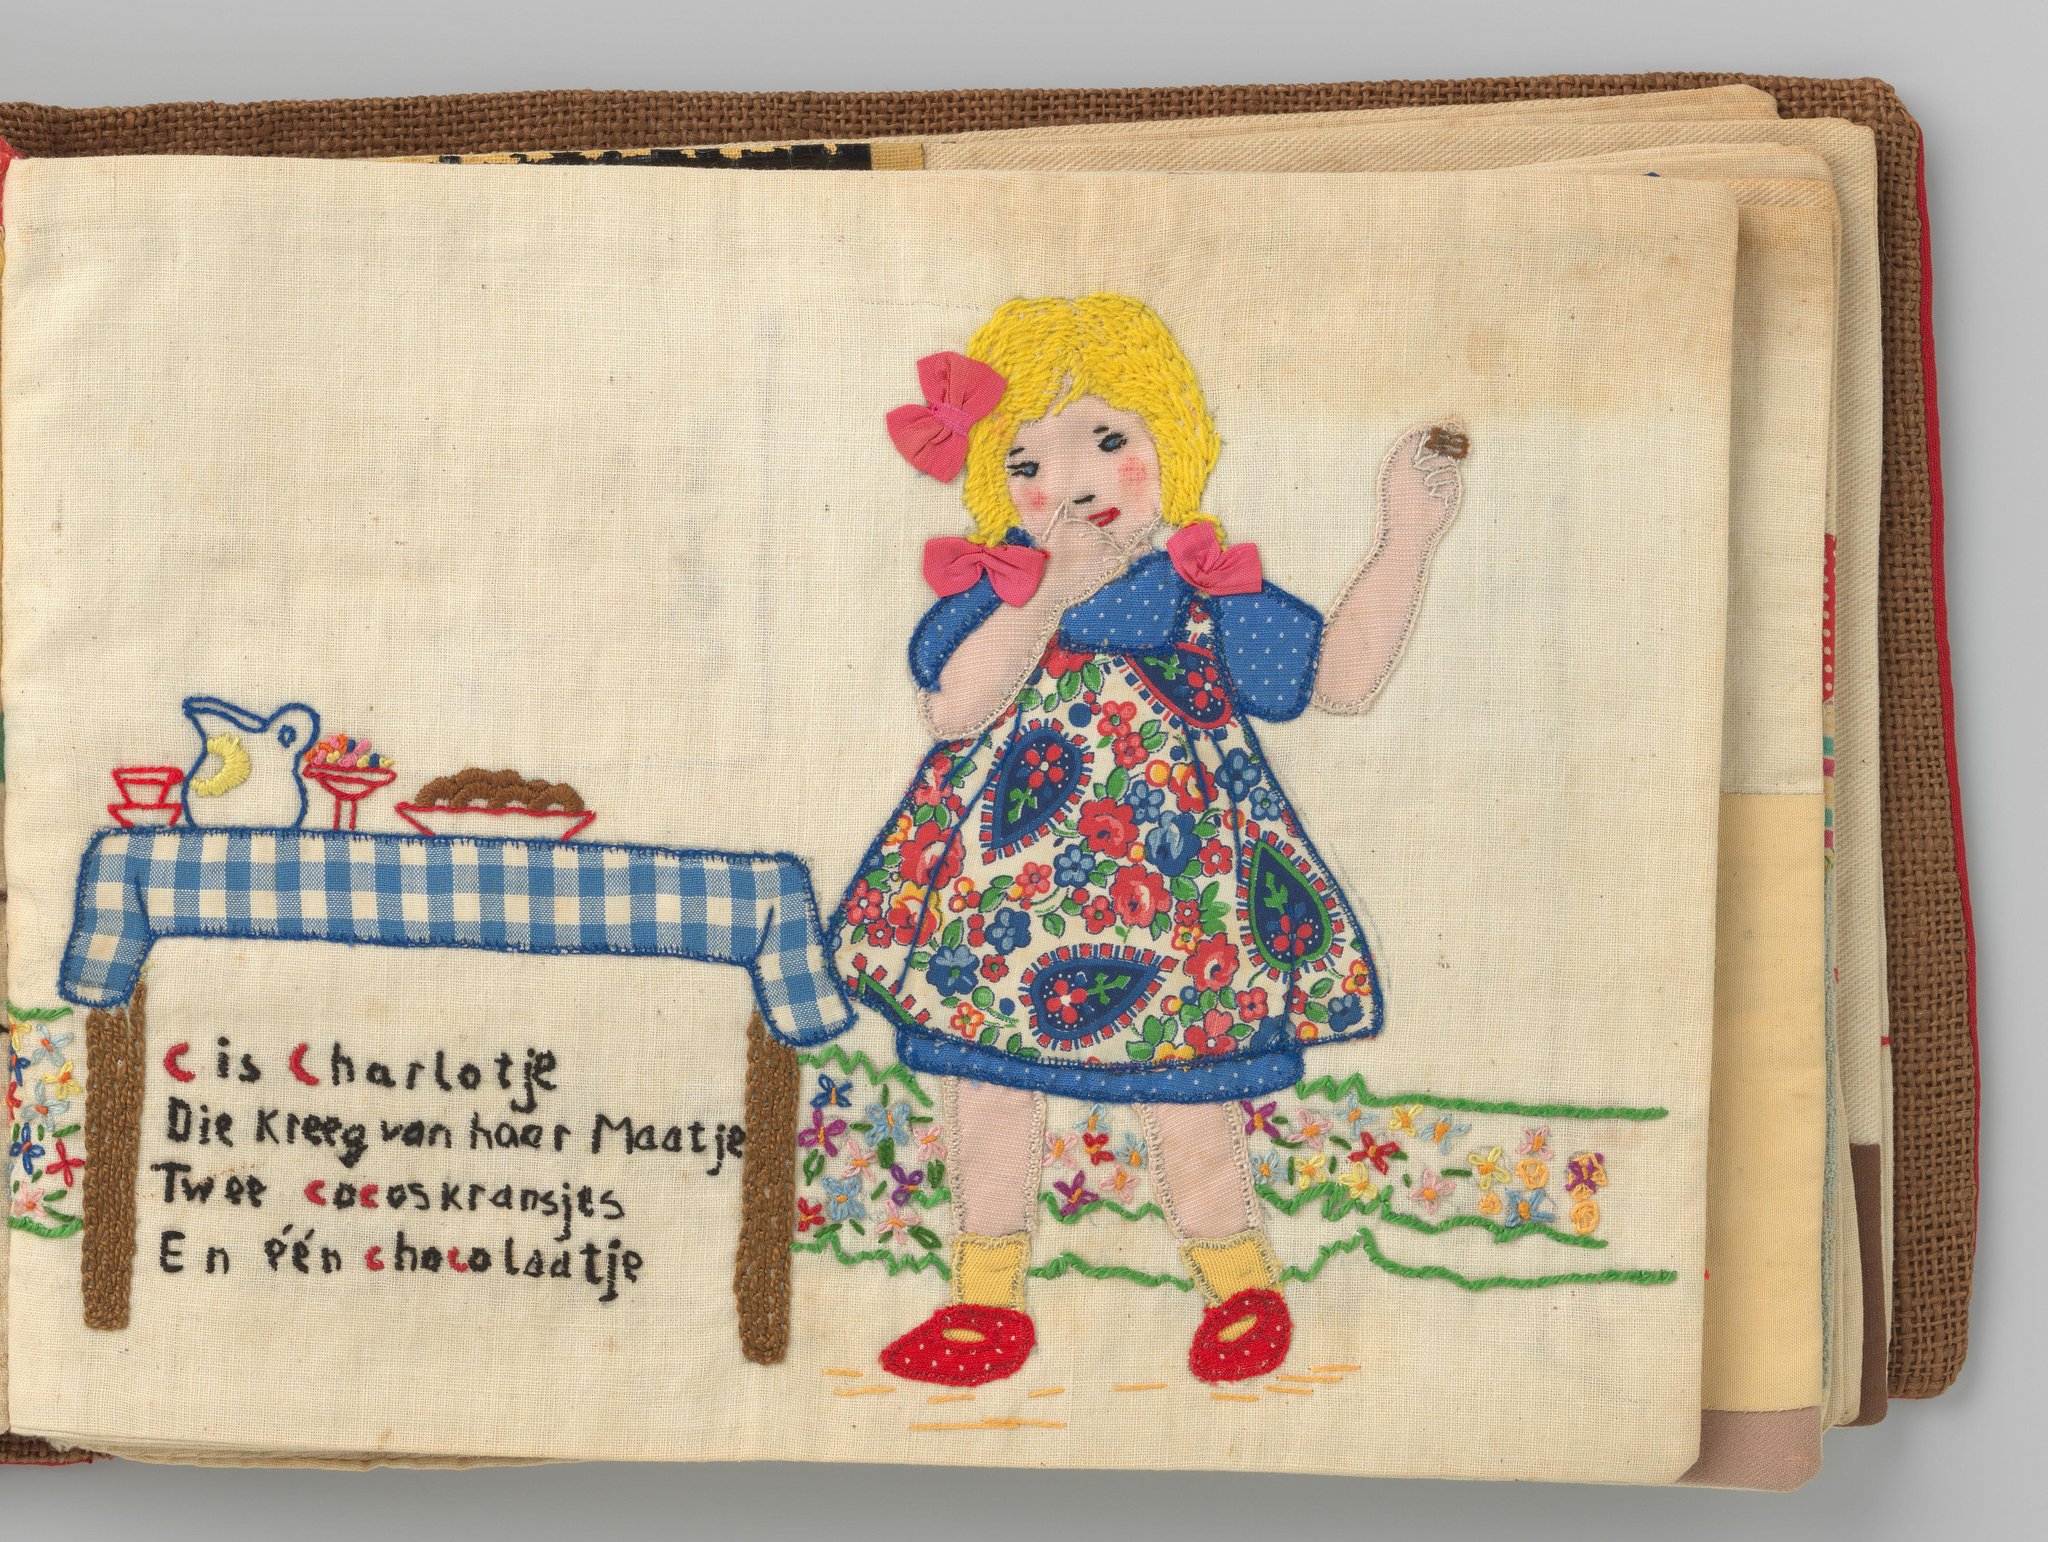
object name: blad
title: C is Charlotje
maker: miesje geertruida maria petronella aalbersberg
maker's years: 1915-1997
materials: cotton, textile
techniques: appliqué, embroidered, stitch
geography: brastagi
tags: reading, book in which illustrations are essential, letters, alphabet, script, internment camp, nursery school (+ teaching aids), (other forms of) needlework, e.g.: crocheting, knitting, embroidering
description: In het geheim gemaakt kinderboek in textiel vrij naar A is een Aapje van Rie Cramer. Het werd gezamenlijk gemaakt door de vrouwelijke gevangenen van het Japanse interneringskamp Brastagi, een oude plantage in Noord-Sumatra 60 kilometer ten zuiden van Medan aan de weg naar het Toba-meer, tijdens de Tweede Wereldoorlog ter gelegenheid van de vijfde verjaardag van Pem Hagers, de dochter van Miesje Hagers-Aalbersberg die de ontwerptekeningen en sjablonen had gemaakt.